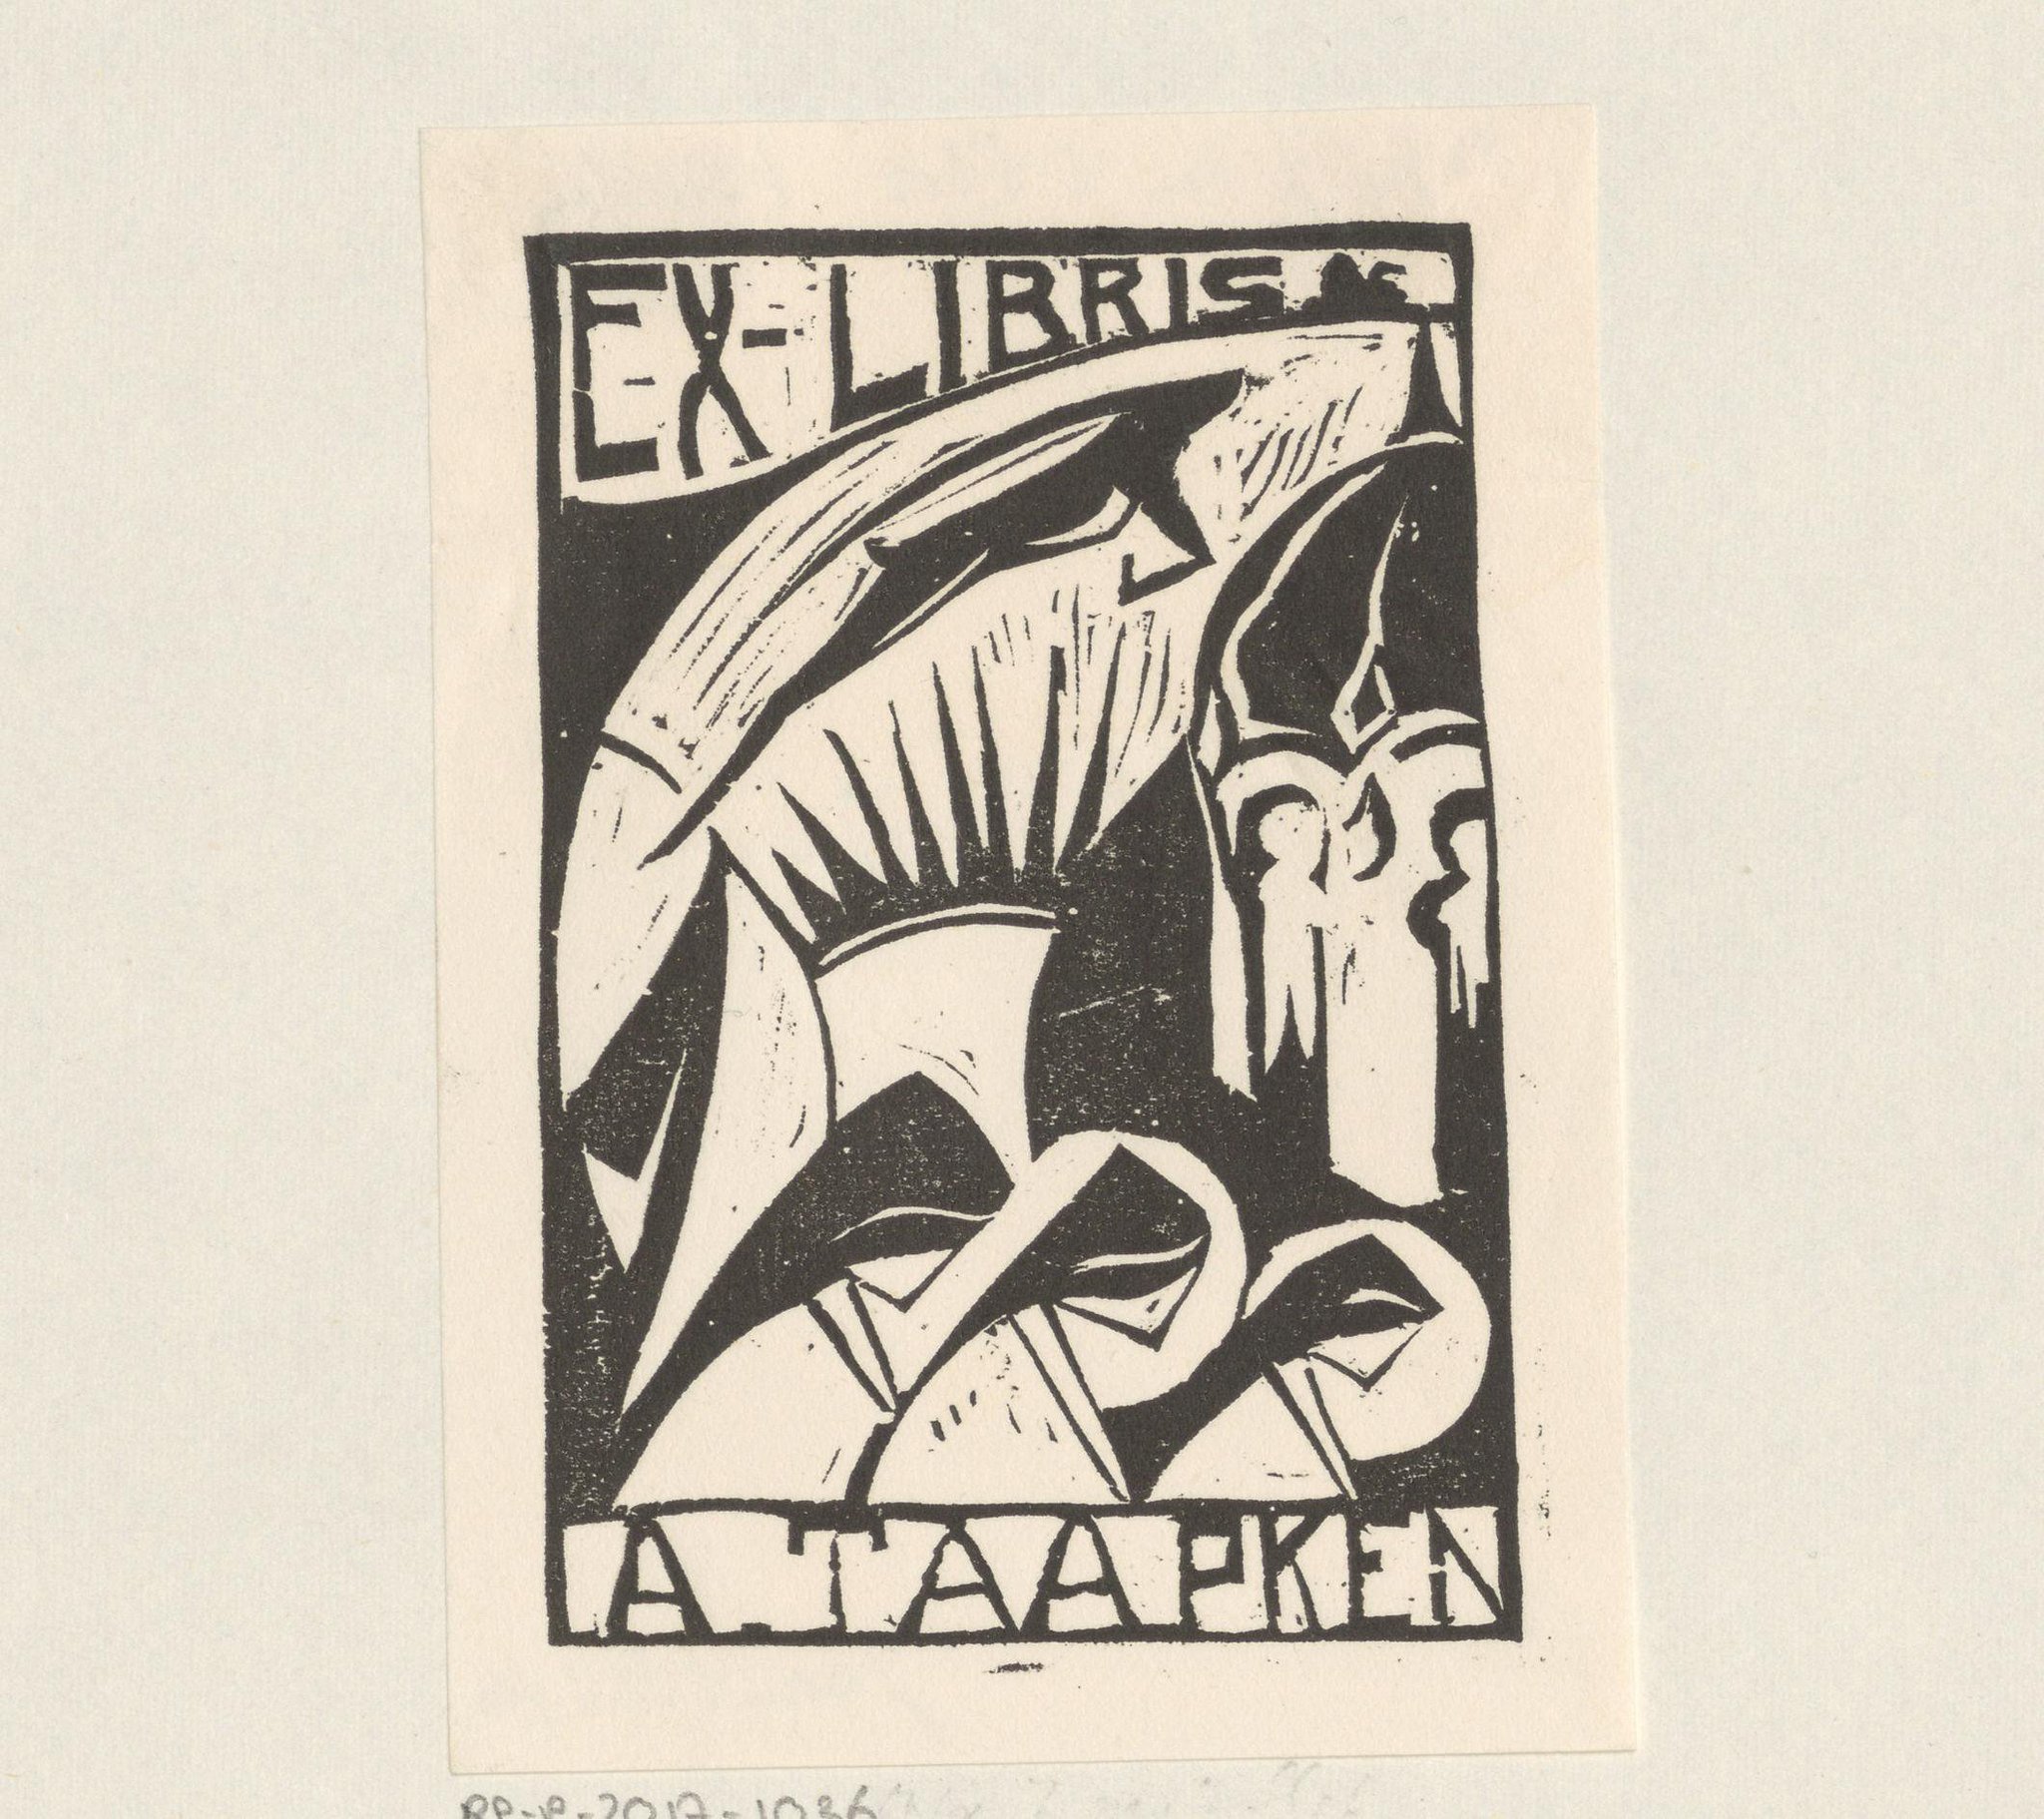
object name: bookplate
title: Ex libris van A. Taapken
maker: jan van t slot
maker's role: painter, print maker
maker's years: 1904-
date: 1928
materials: paper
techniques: linocut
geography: netherlands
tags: nun(s), hoofed animals: stag, one person praying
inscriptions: inscription: ‘J. van 't Slot fec.’